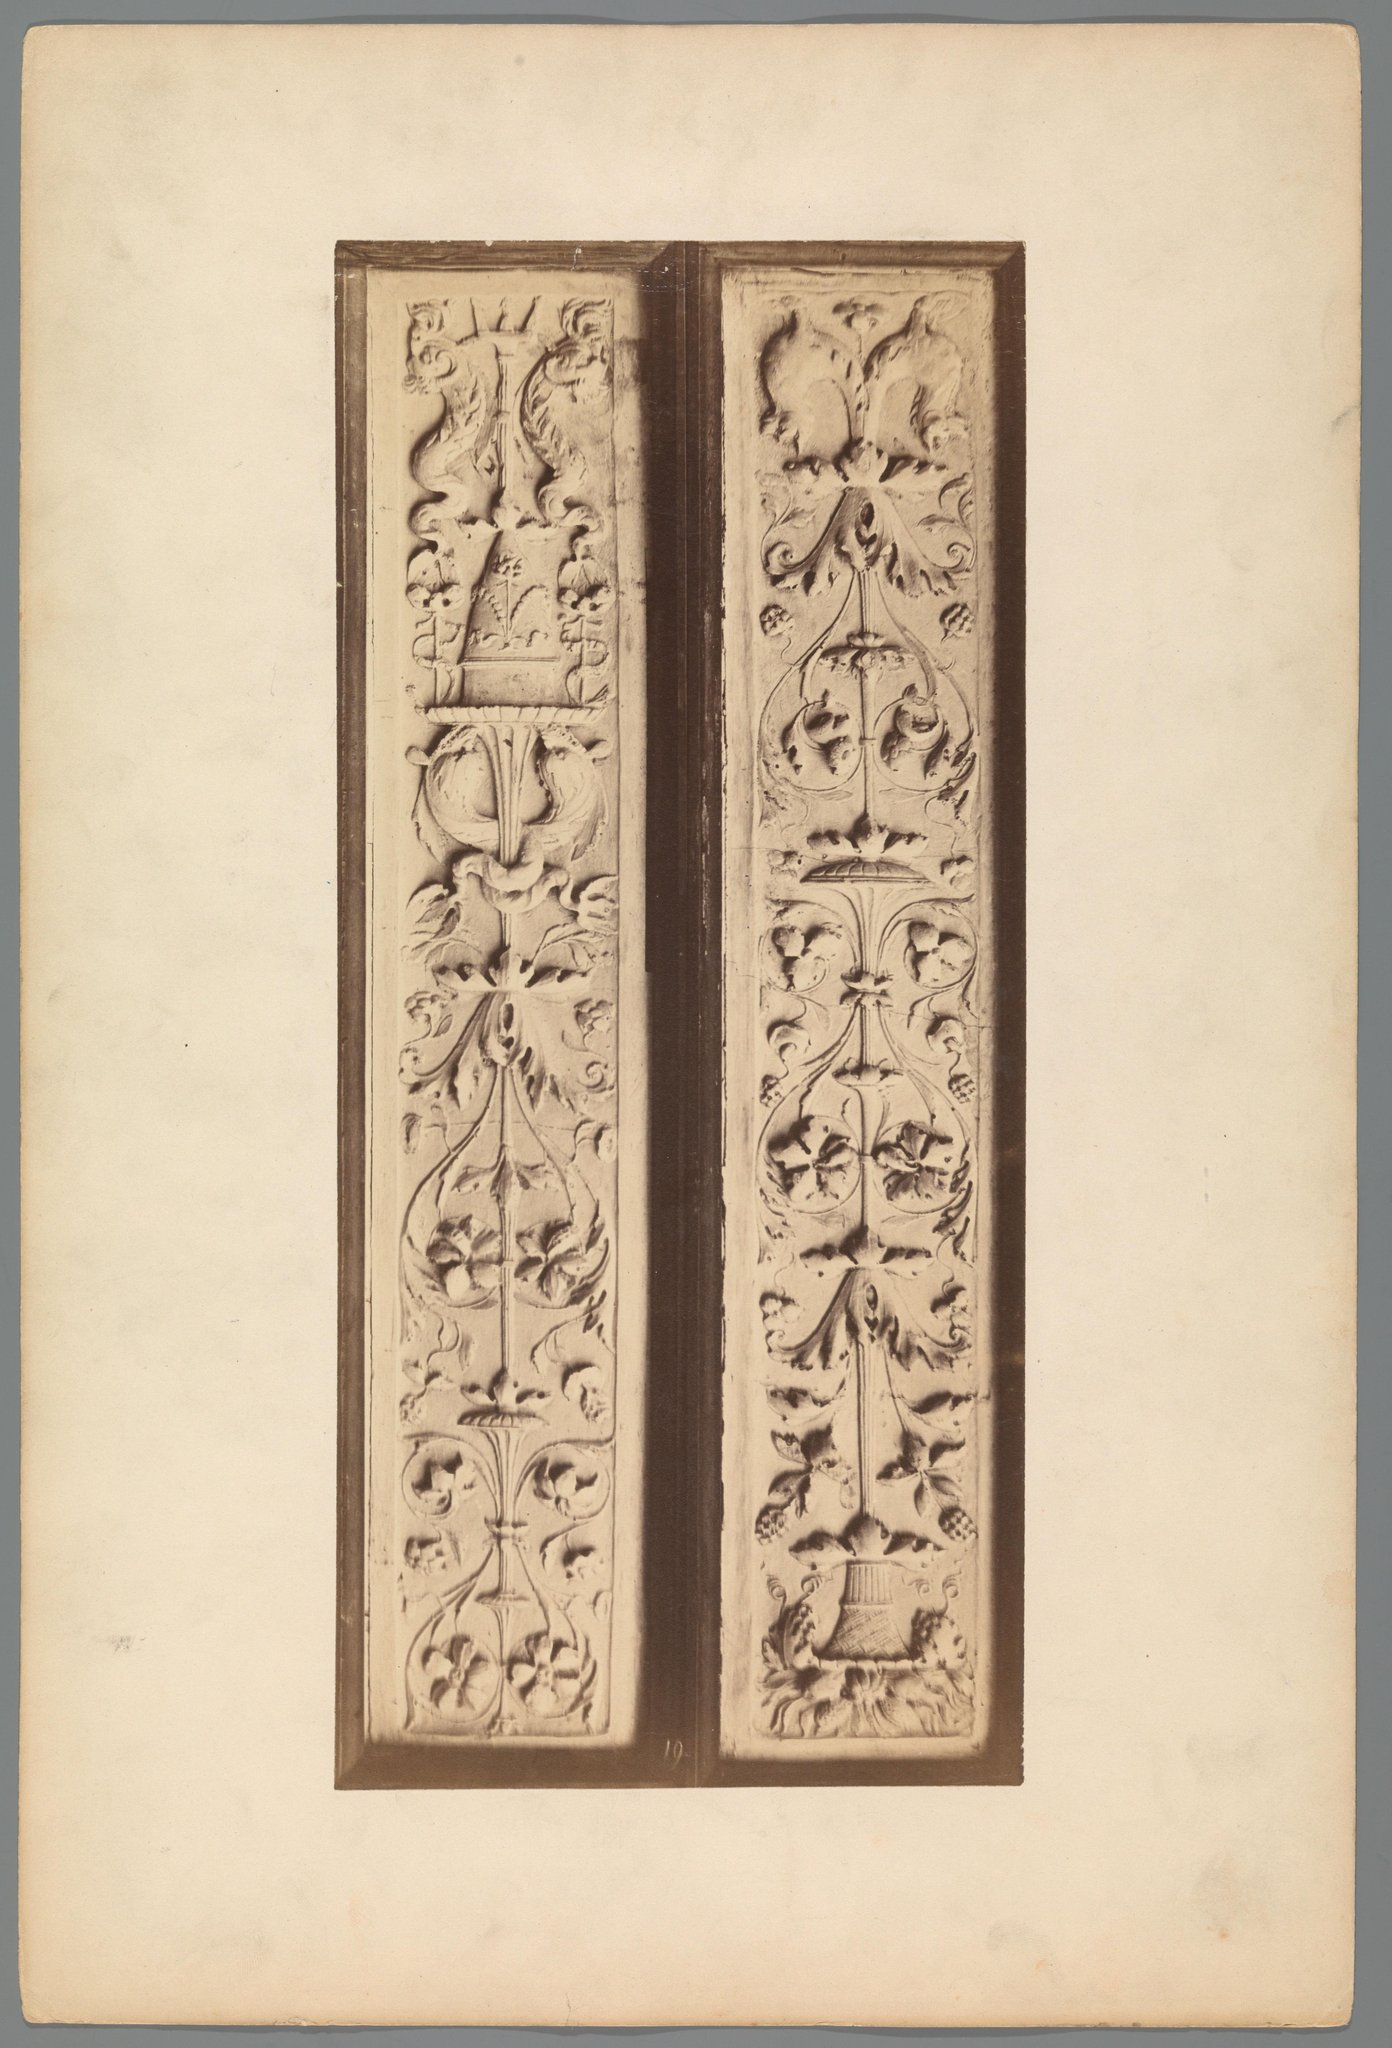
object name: photograph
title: Twee langwerpige reliëfs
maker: pompeo pozzi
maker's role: fotograaf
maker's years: 1817-1880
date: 1850-1880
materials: cardboard, photographic support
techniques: albumen print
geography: europe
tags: ornament ~ hybrid animals, fruits and vegetables ~ ornament, ornament derived from plant forms, sculpture (+ relief ~ sculpture), europe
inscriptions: collector's mark: Lugt 3937, number: ‘61’, name: ‘FOTOGRAFIA ARTISTICA P.POZZI MILANO’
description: Links een reliëf met plantmotieven en fruit, rechts een reliëf met plantmotieven en fantasiewezen.